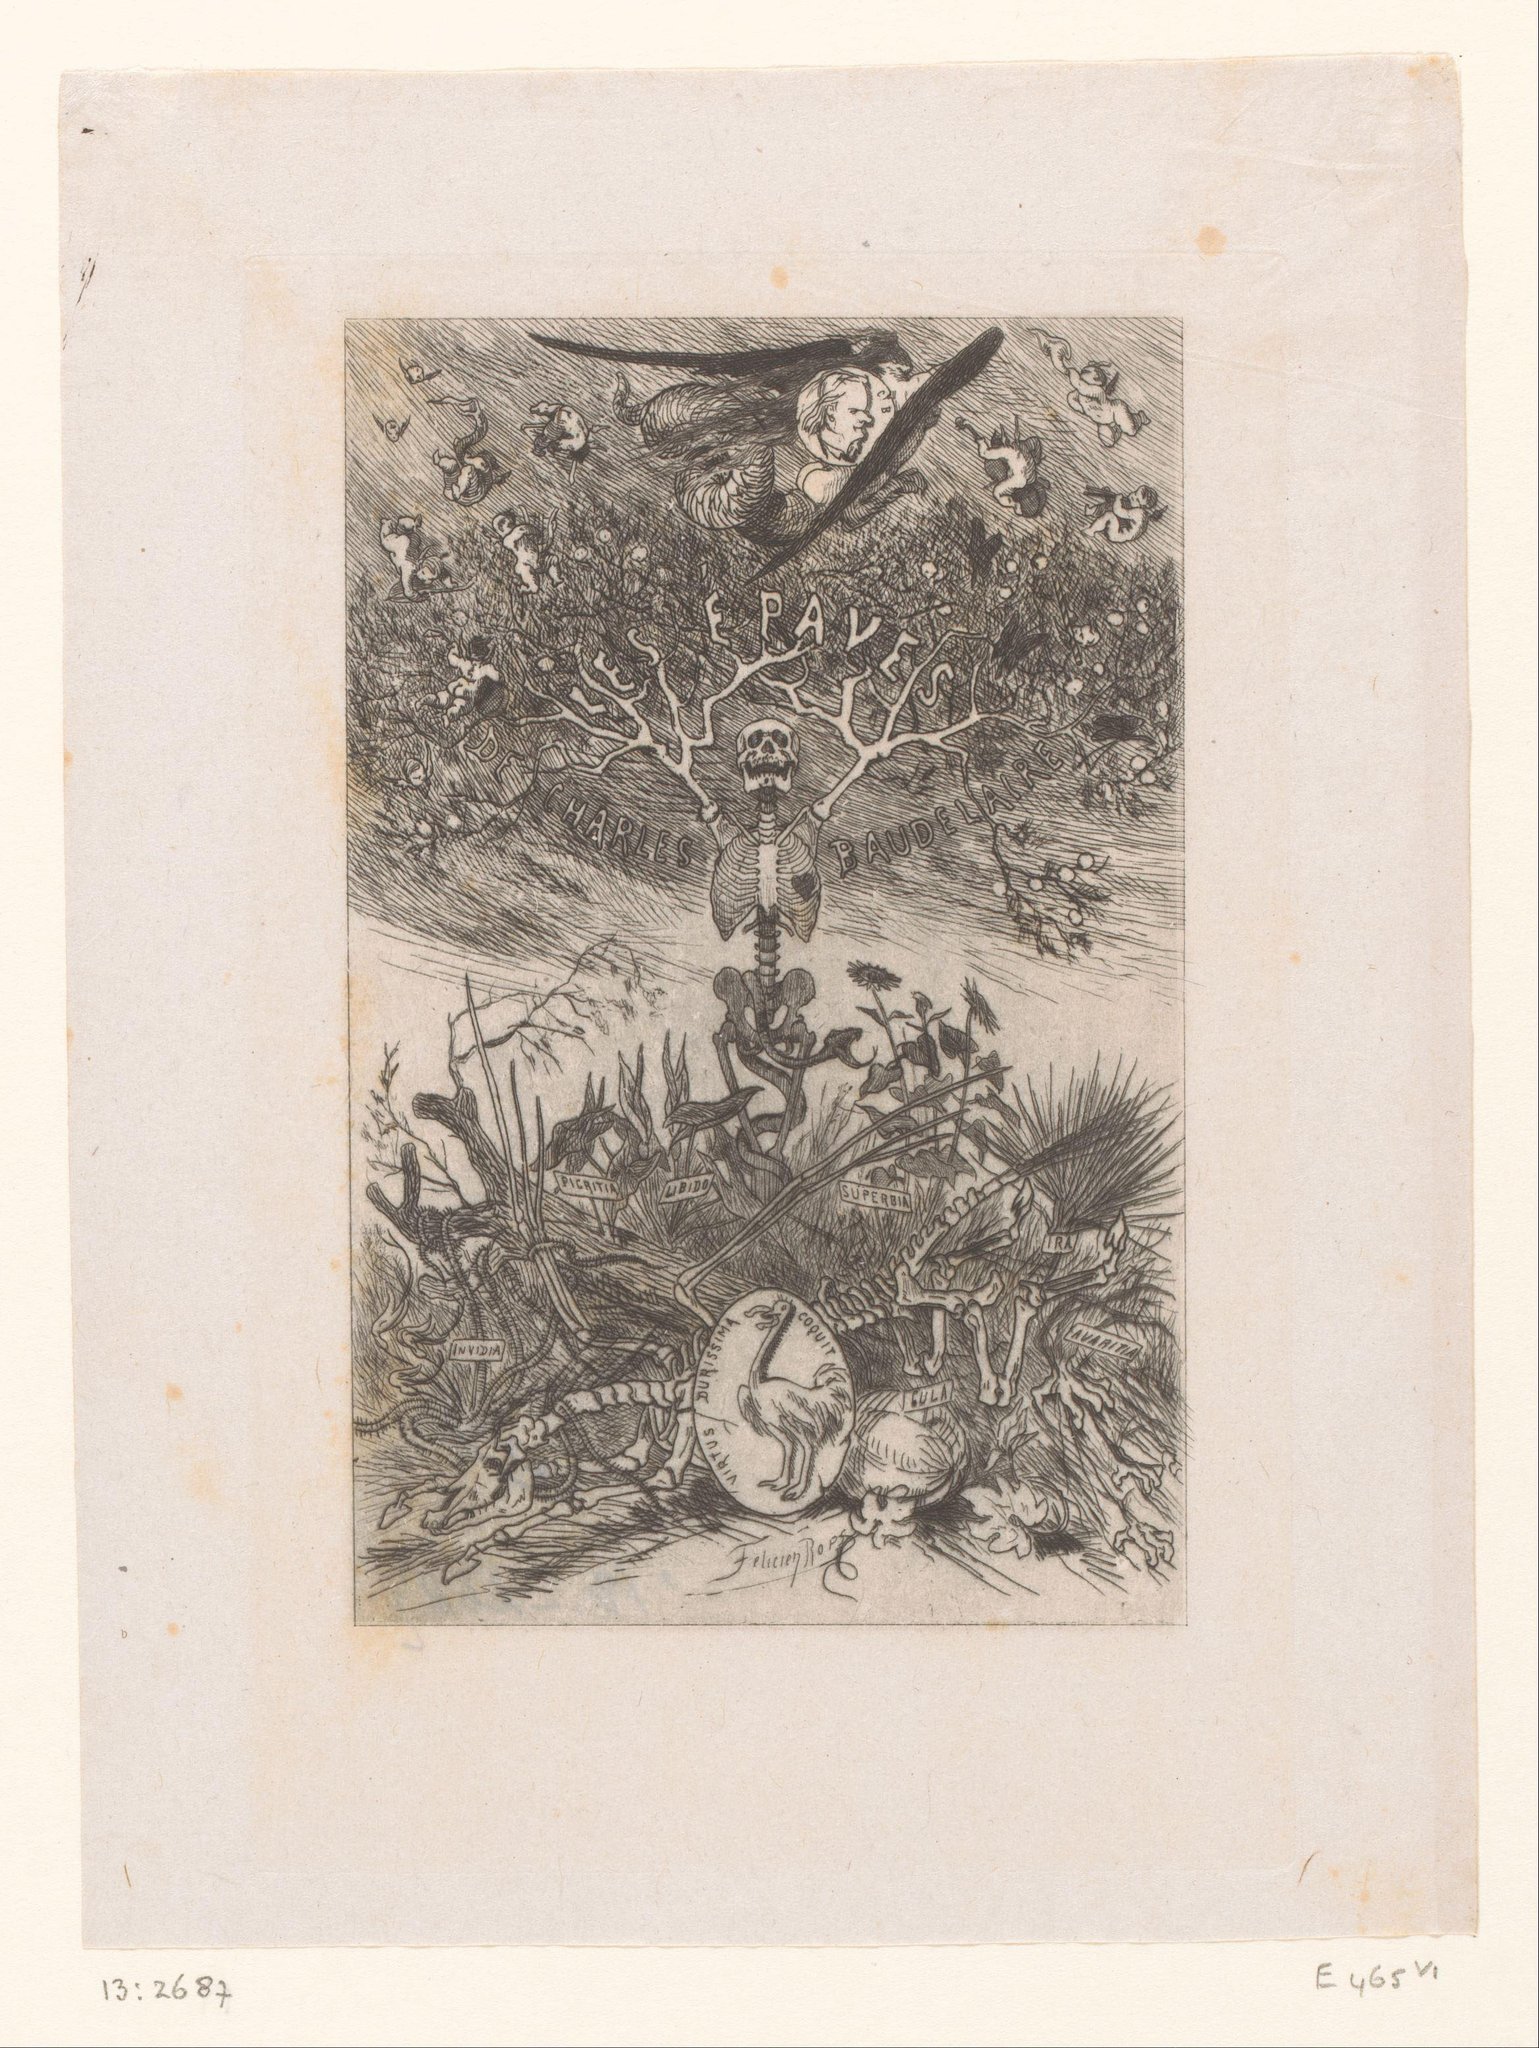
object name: print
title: Allegorie op zonden met een skelet waaruit takken ontspruiten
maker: félicien rops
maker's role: draughtsman, print maker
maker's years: 1833-1898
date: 1866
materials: paper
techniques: drypoint, etching, intaglio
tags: vice, and the seven deadly sins, (human) skeleton, cupids: 'amores', 'amoretti', 'putti'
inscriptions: collector's mark: Lugt 2228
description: De laatste staat van deze prent is gebruikt als illustratie tegenover de titelpagina in: Baudelaire, Charles. Les épaves. Amsterdam: À l'enseigne du Coq [=Brussel: A. Poulet-Malassis], 1866.